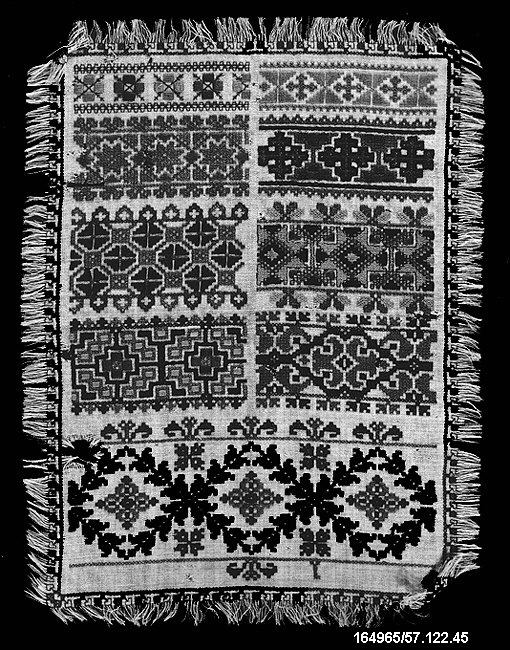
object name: sampler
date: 1801-1900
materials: wool